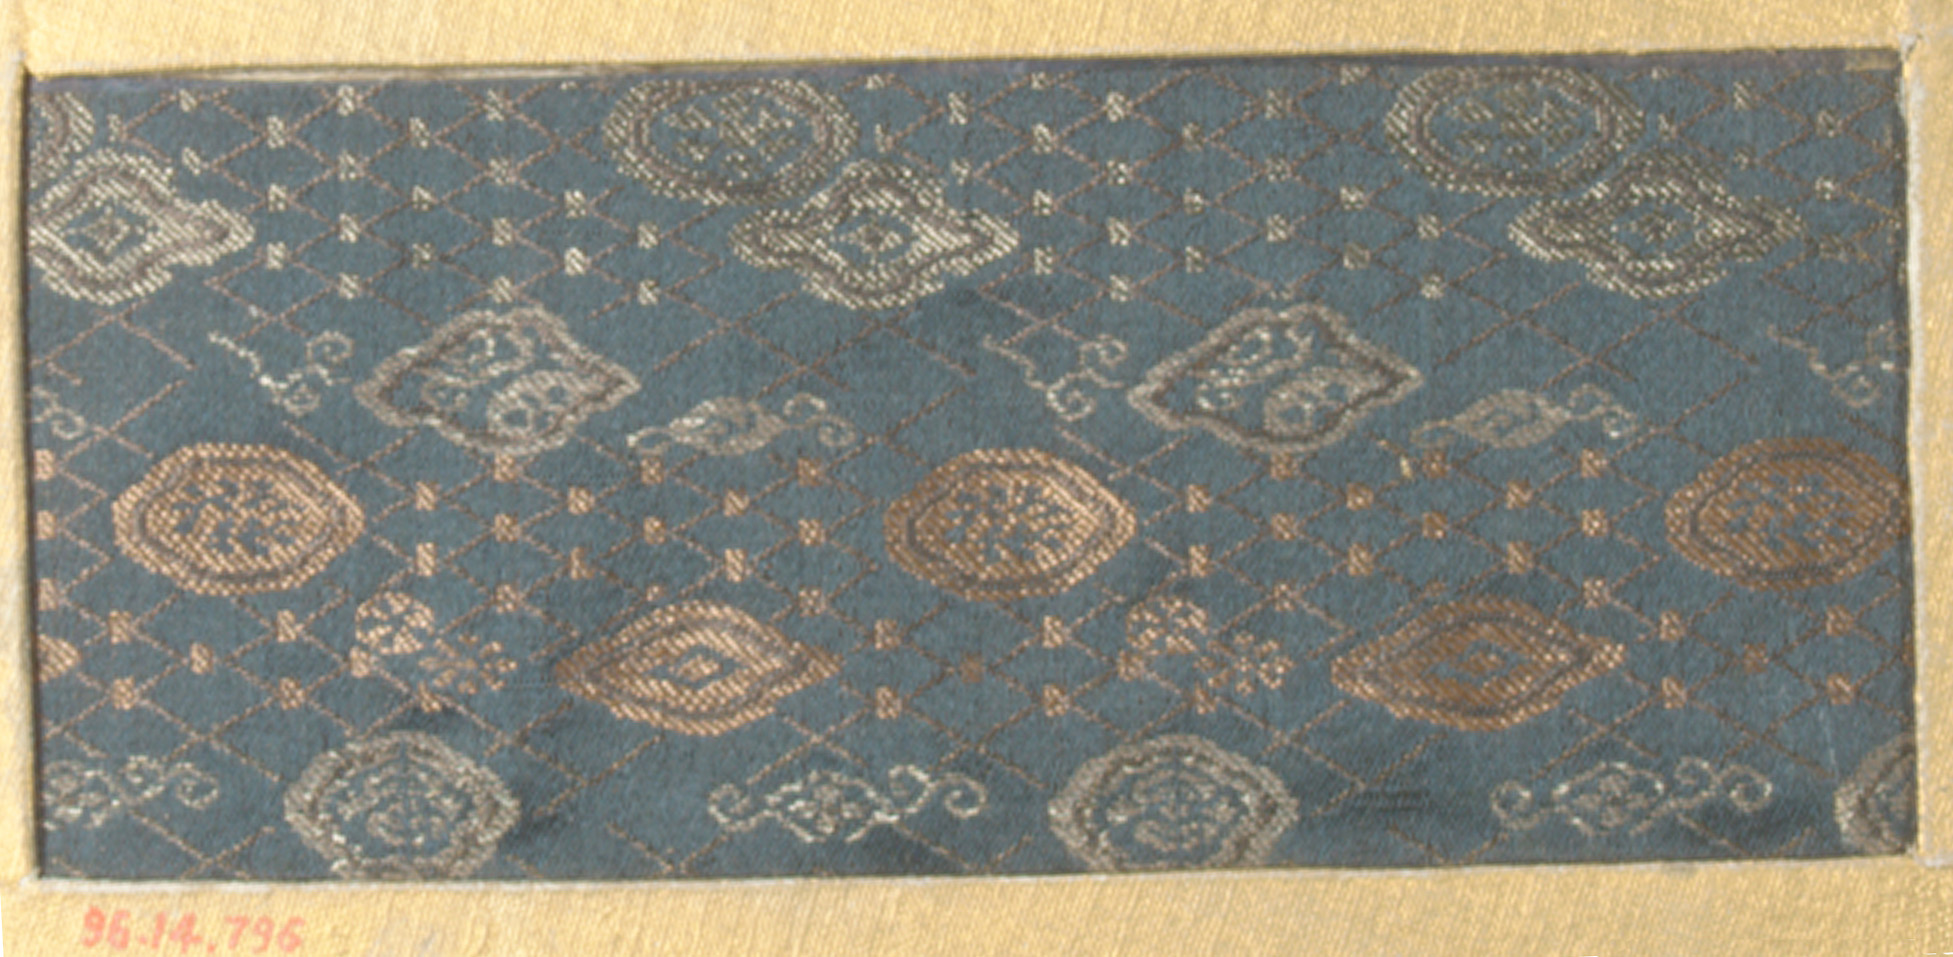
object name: piece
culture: japanese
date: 1701-1900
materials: silk